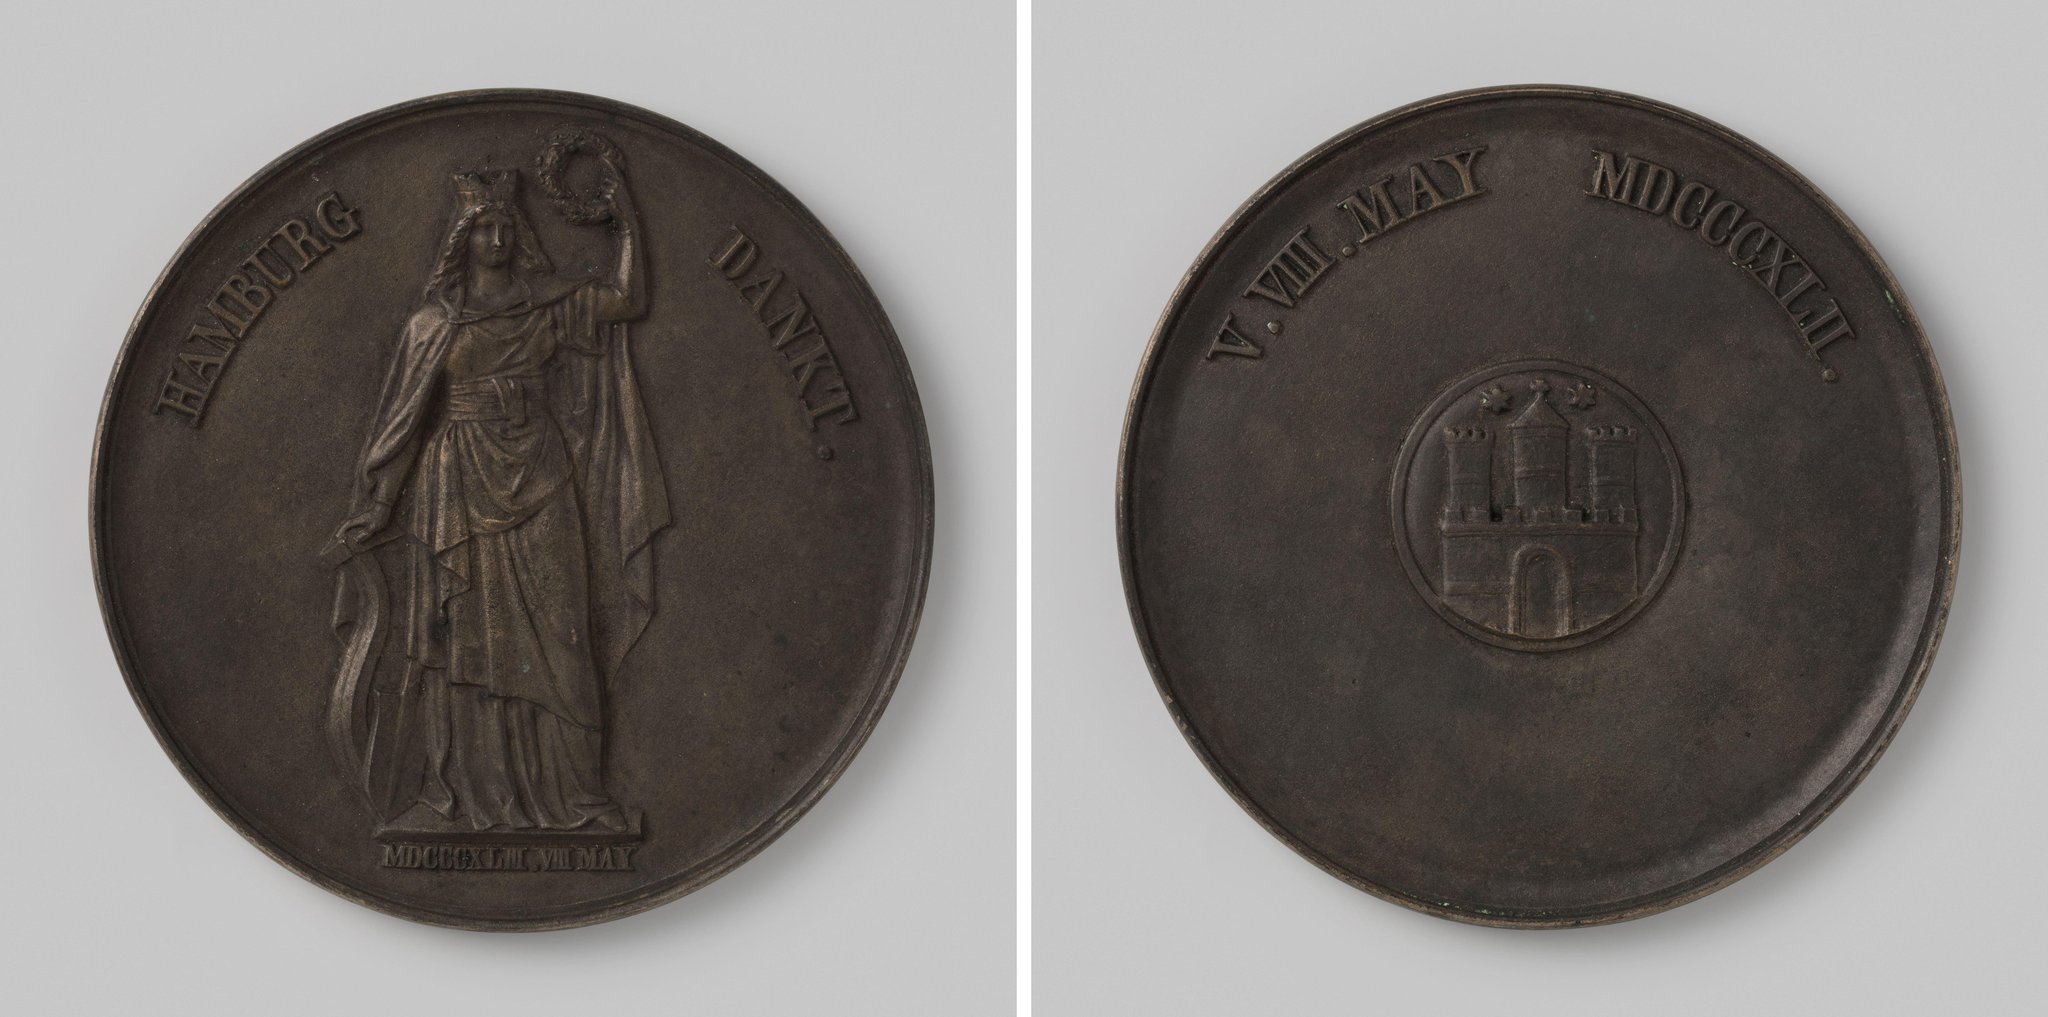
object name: history medal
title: Erkentenis van de stad Hamburg na de brand van 1842 (1843)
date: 1843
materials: bronze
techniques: casting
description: Bijzonder grote bronzen penning, op de voorzijde een staande stadsgodin met lauwerkrans, met omschrift en afsnedetekst, op de keerzijde een medaillon met het Hamburger stadswapen, met bovenaan omschrift.